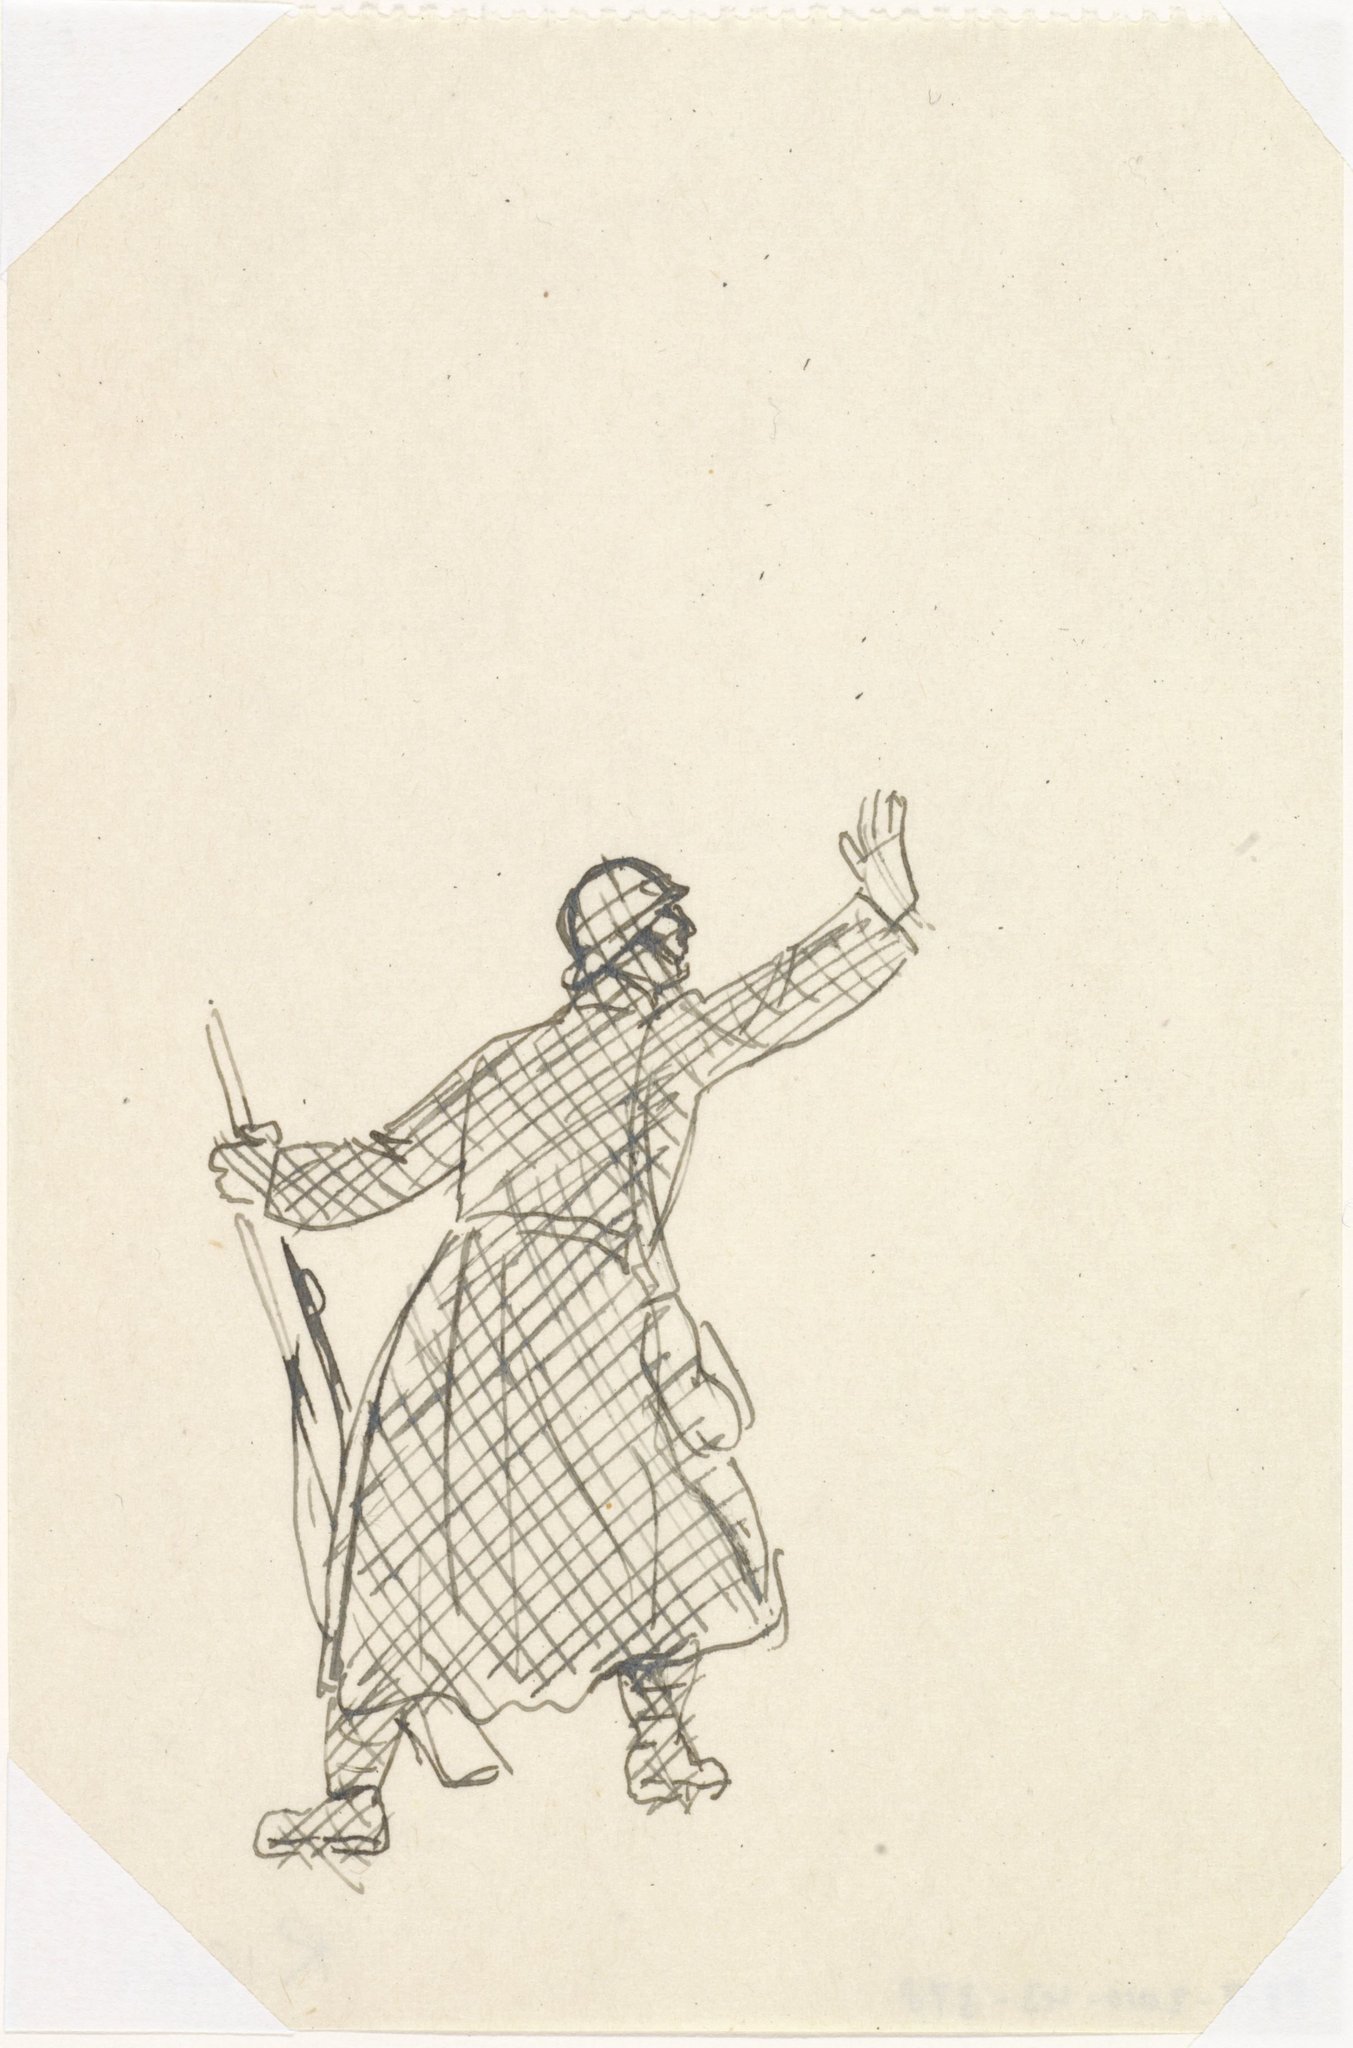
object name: drawing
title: Zonder titel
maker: leo gestel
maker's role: draughtsman, print maker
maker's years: 1881-1941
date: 1939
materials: ink, paper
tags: non-combatants ~ war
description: Soldaat op de rug gezien, met de rechterhand een stopteken makend en in de linkerhand een geweer, die rust op de grond